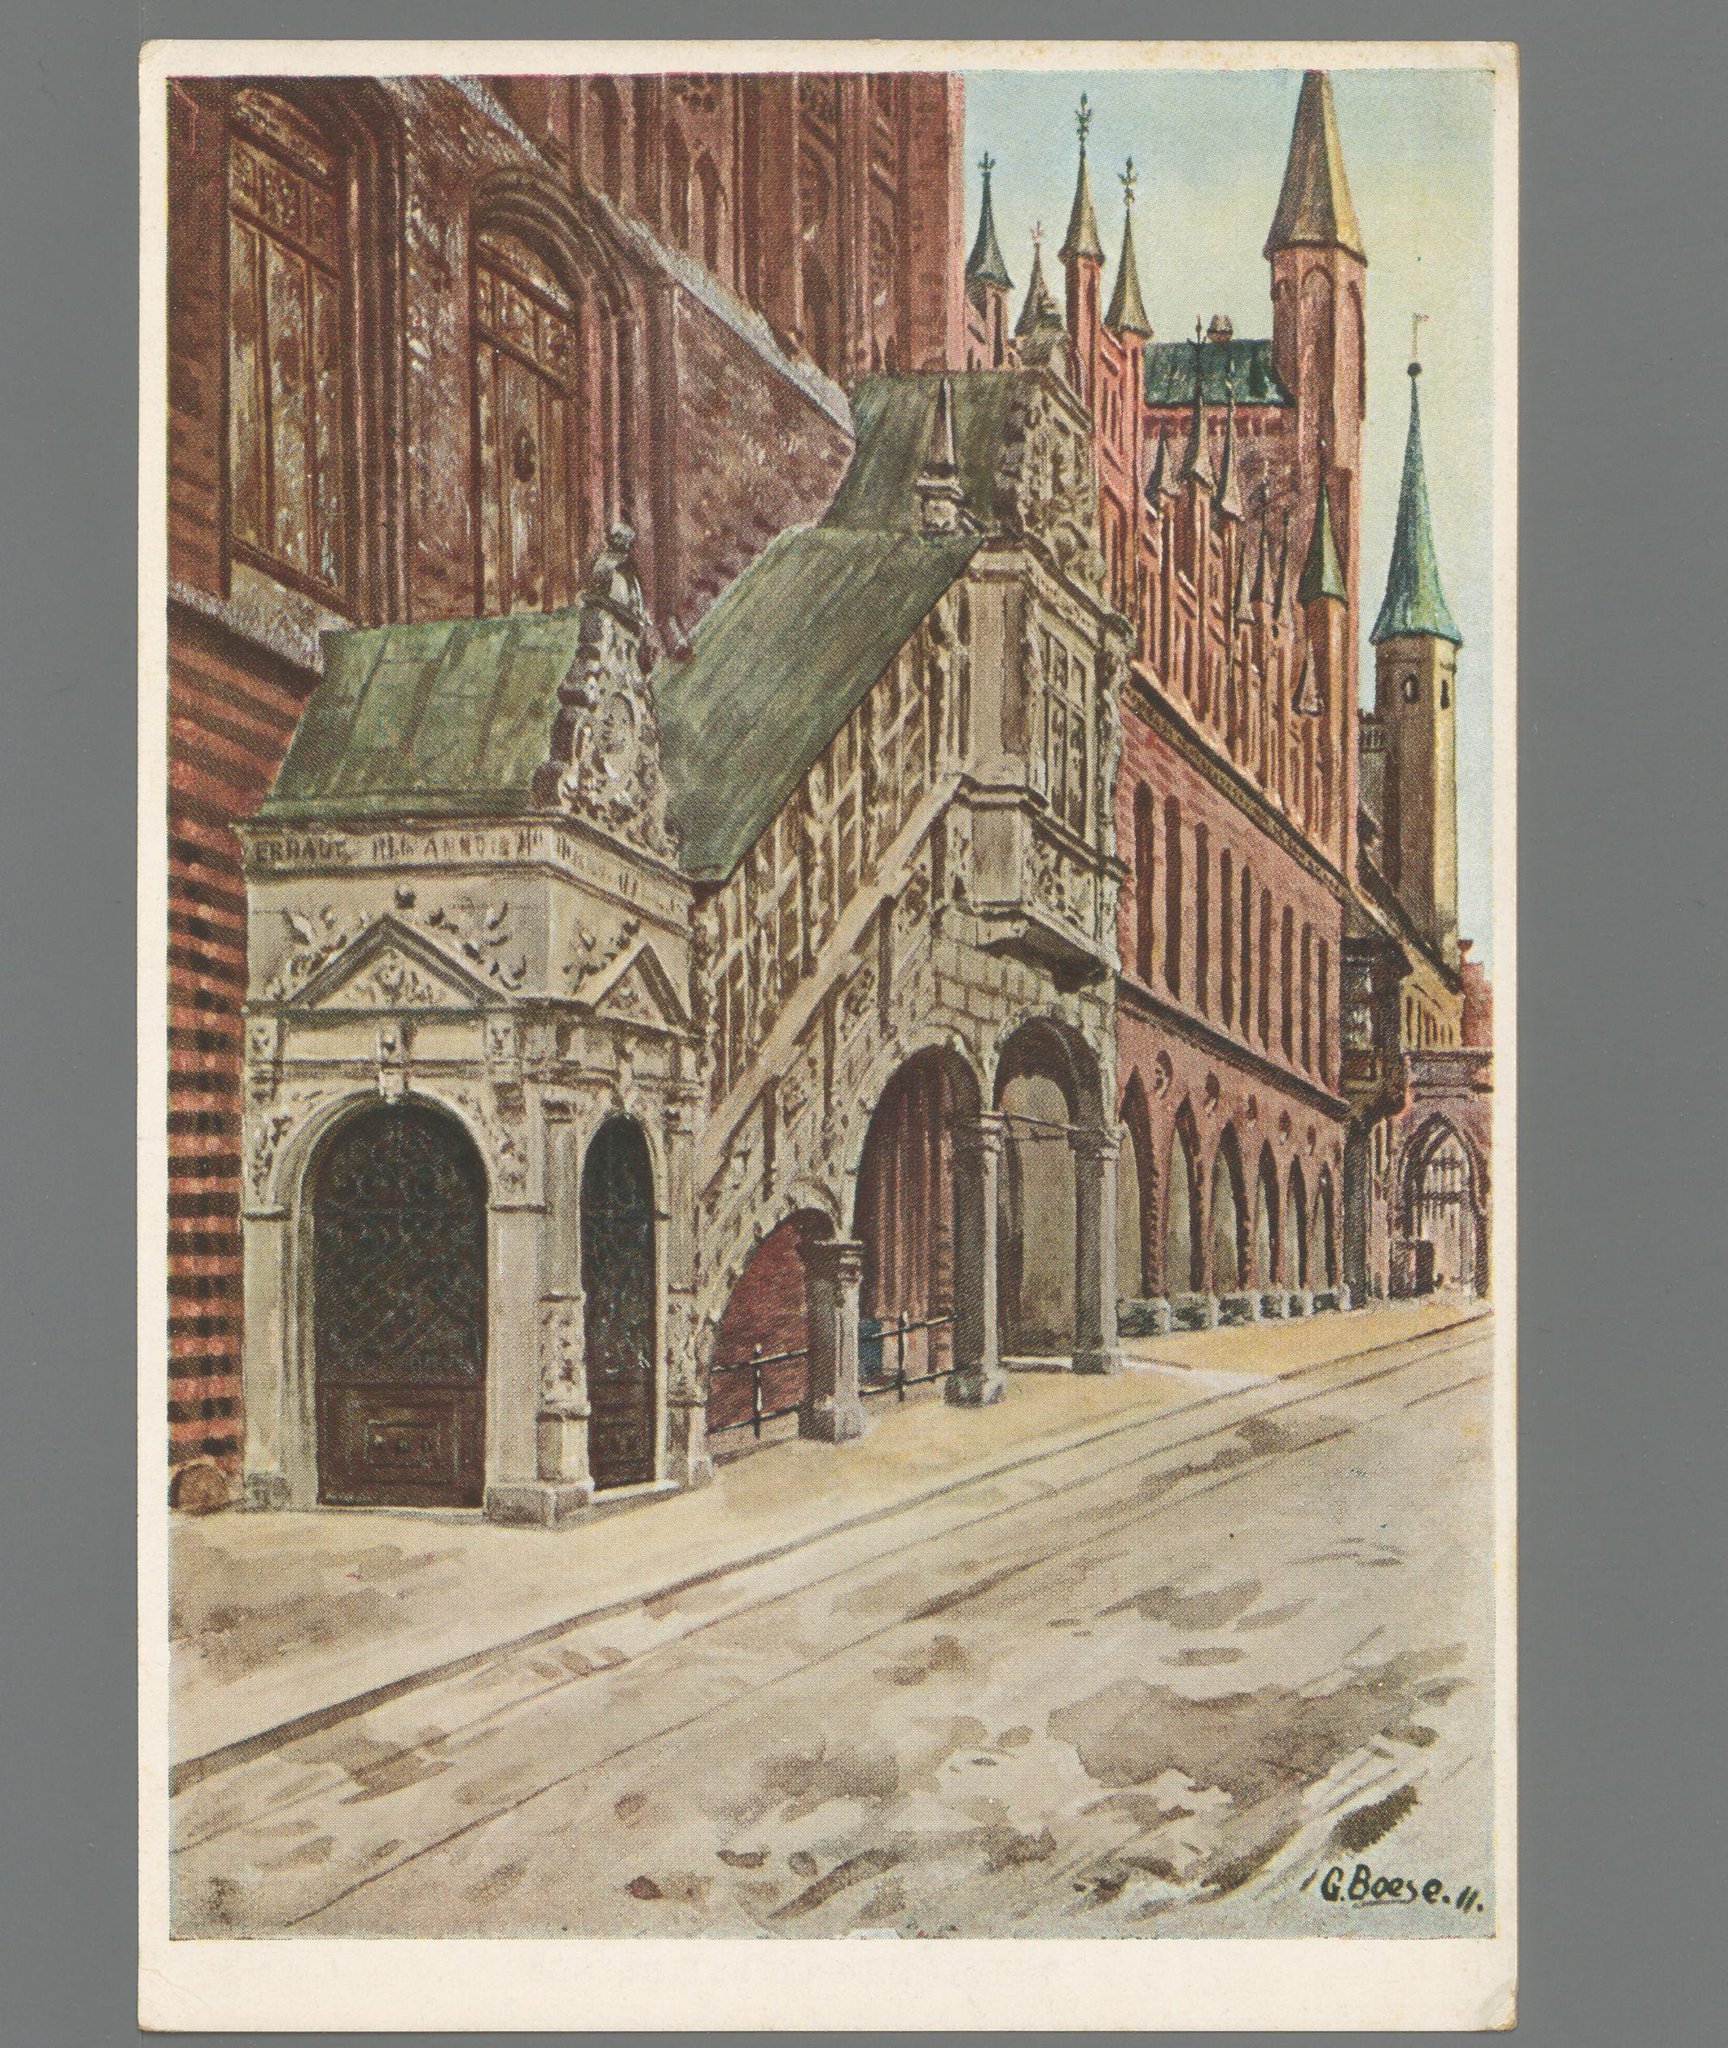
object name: ansichtkaart, prentbriefkaart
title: Lübeck. Rathaus von der Breitenstraβe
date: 1911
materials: cardboard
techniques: color autotype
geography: lübeck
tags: townhall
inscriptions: date